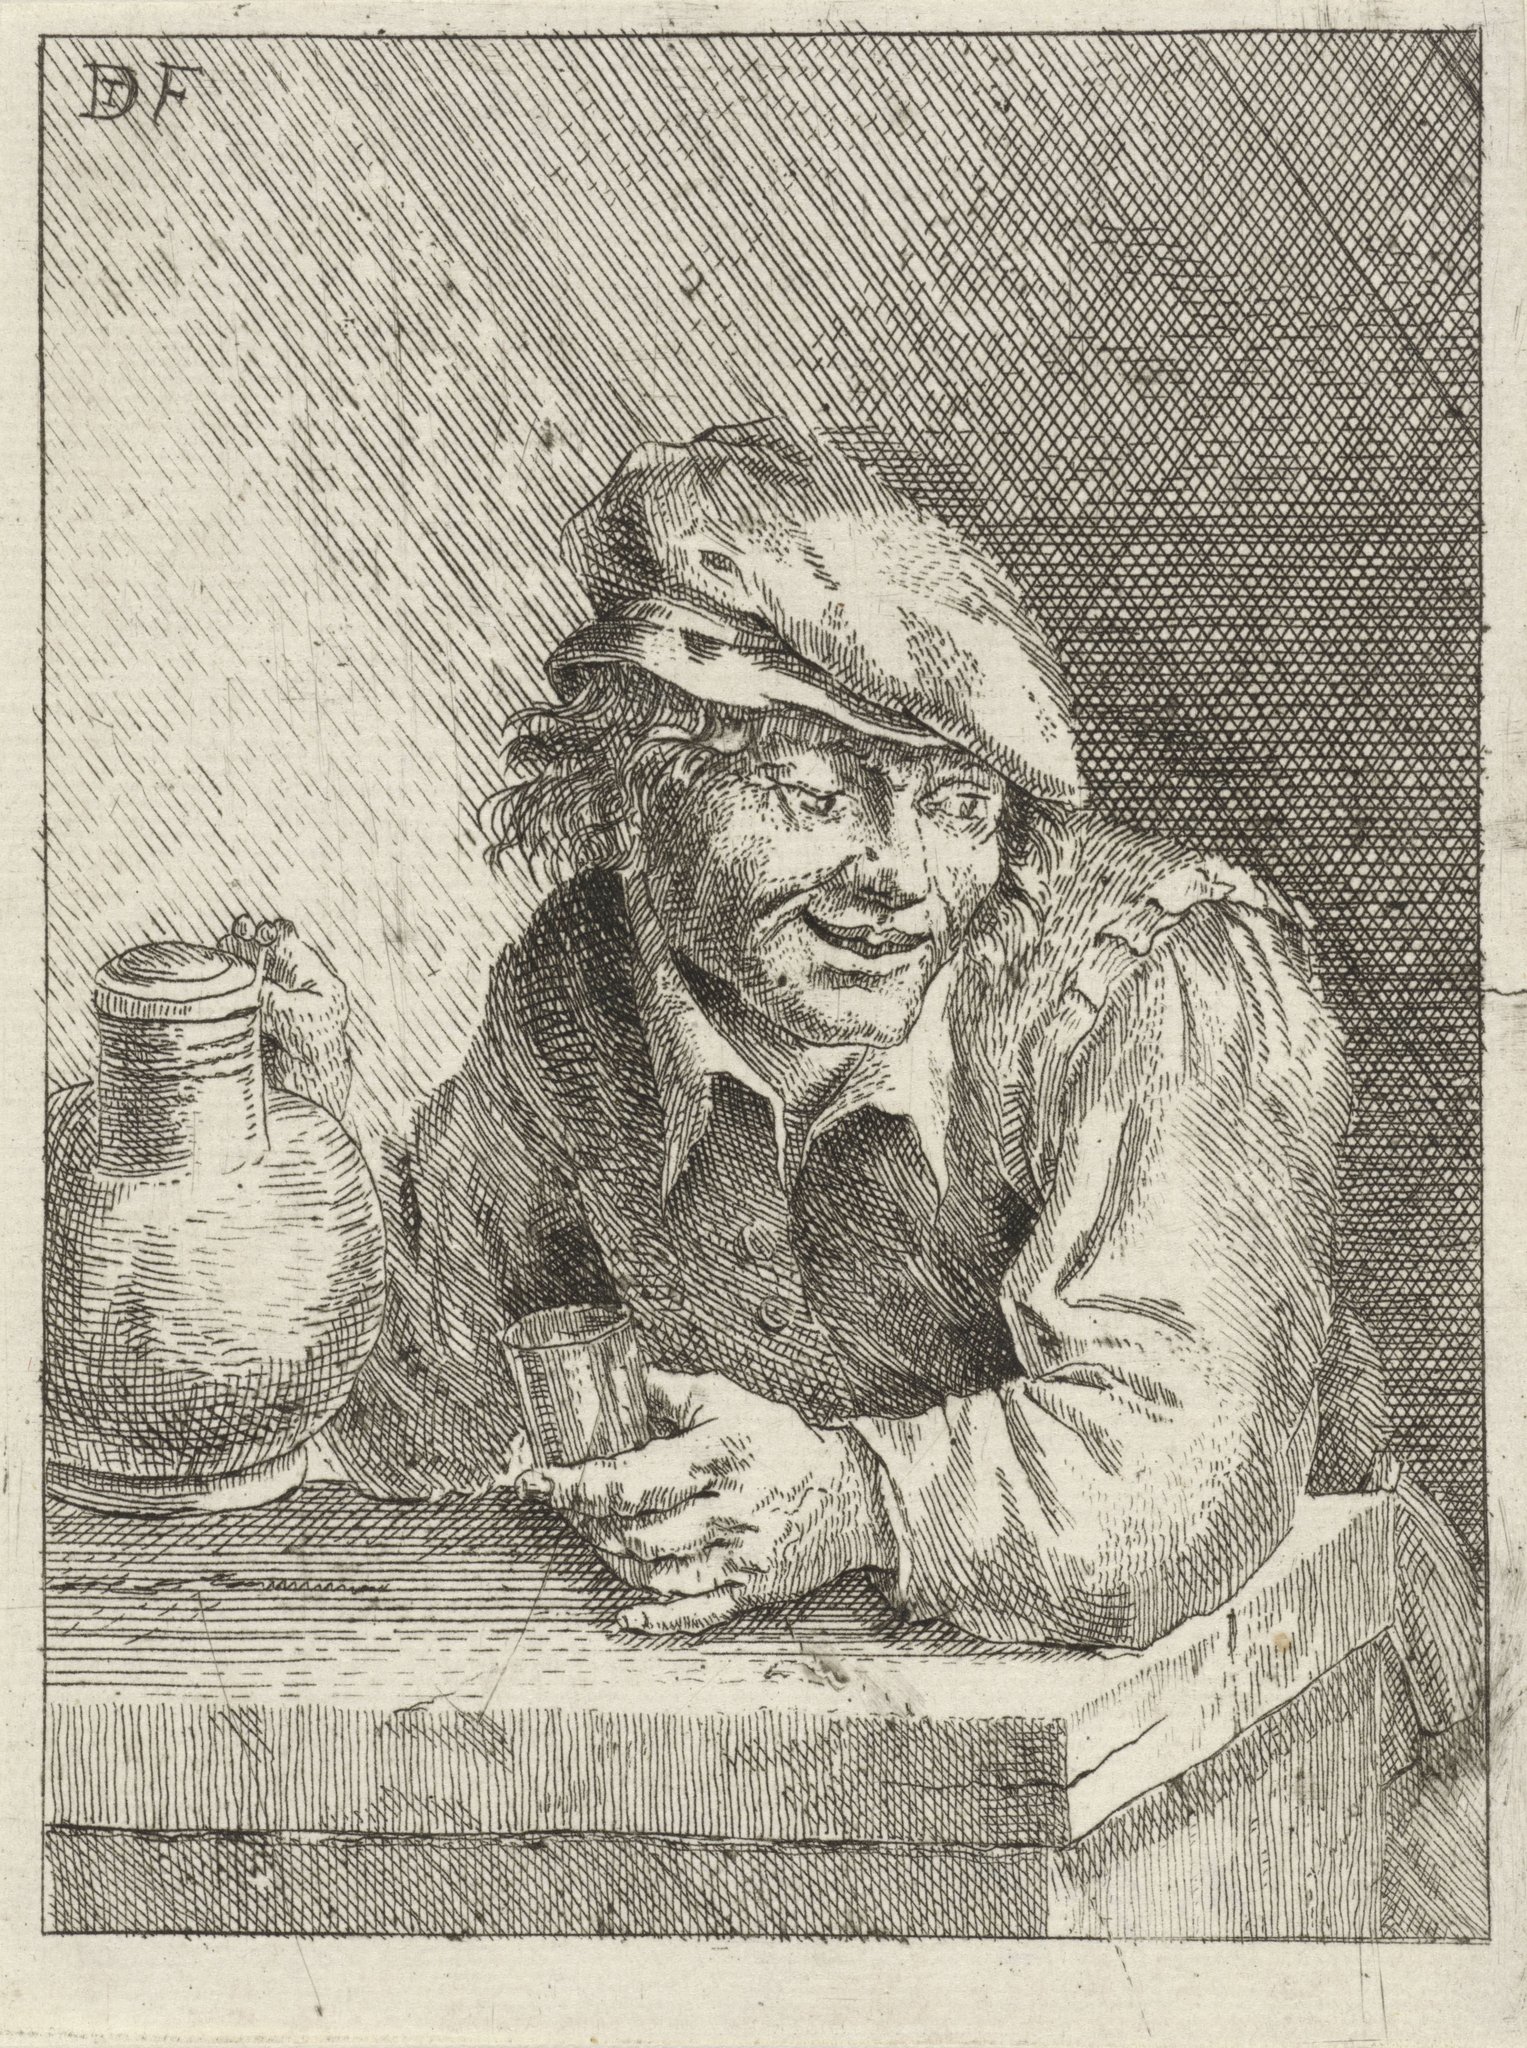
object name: print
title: Boer aan een toog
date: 1626-1640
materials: paper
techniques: etching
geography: low countries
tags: head-gear: cap (+ men's clothes), glass, rummer, container of ceramics: jar, jug, pot, vase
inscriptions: collector's mark: Lugt 2228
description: Boer achter een toog met een kruik in de ene en een glas in de ander hand.